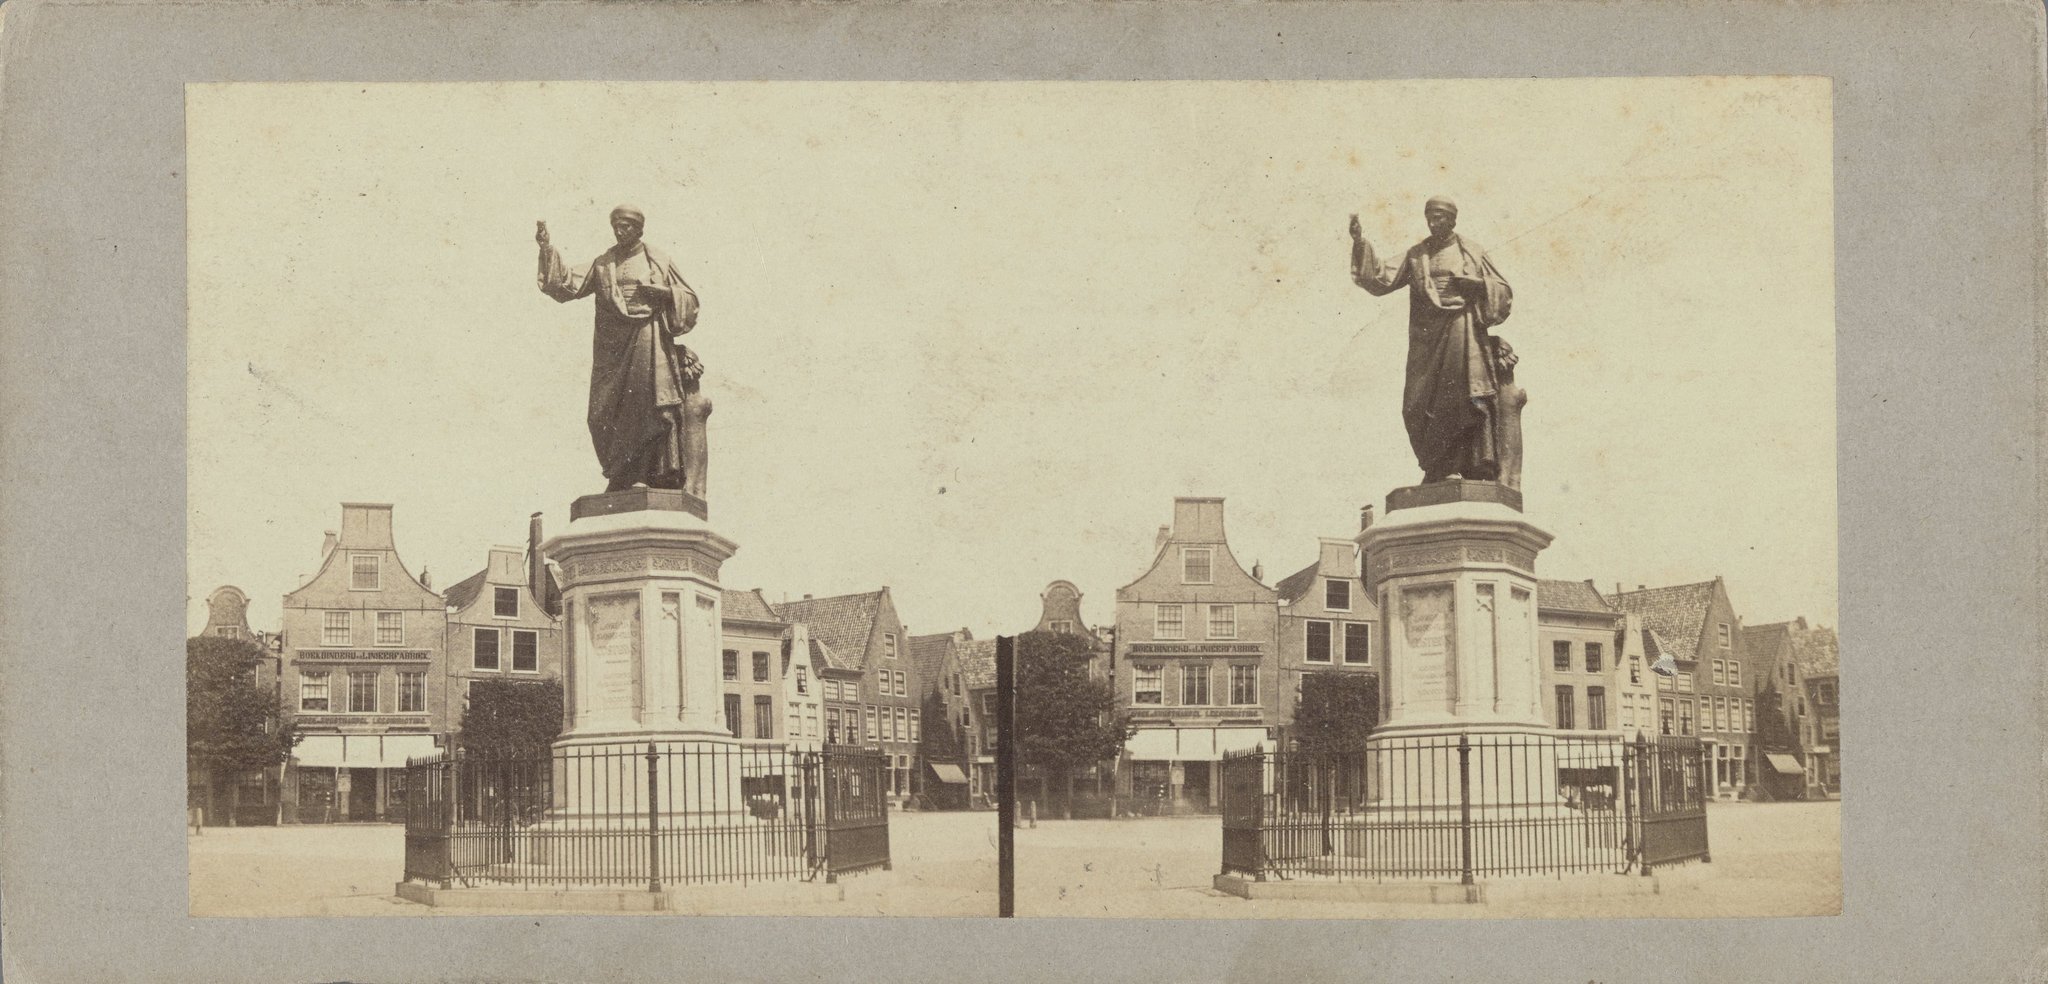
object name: stereograph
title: Gezicht op de Grote Markt in Haarlem met huizen en het standbeeld van Laurens Janszoon Coster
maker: Anonymous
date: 1860-1880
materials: cardboard, paper, photographic support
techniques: albumen print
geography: haarlem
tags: haarlem, monument, statue, square, place, circus, etc. (+ city(-scape) with figures, staffage)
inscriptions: inscription: ‘No. 58. Statue de Koster a Harlem.’